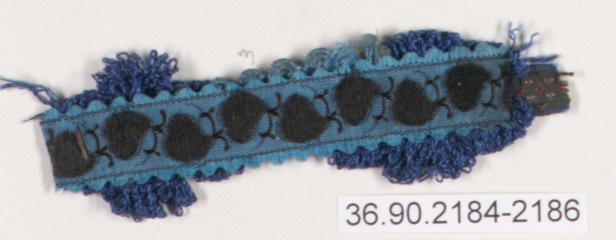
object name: piece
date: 1801-1900